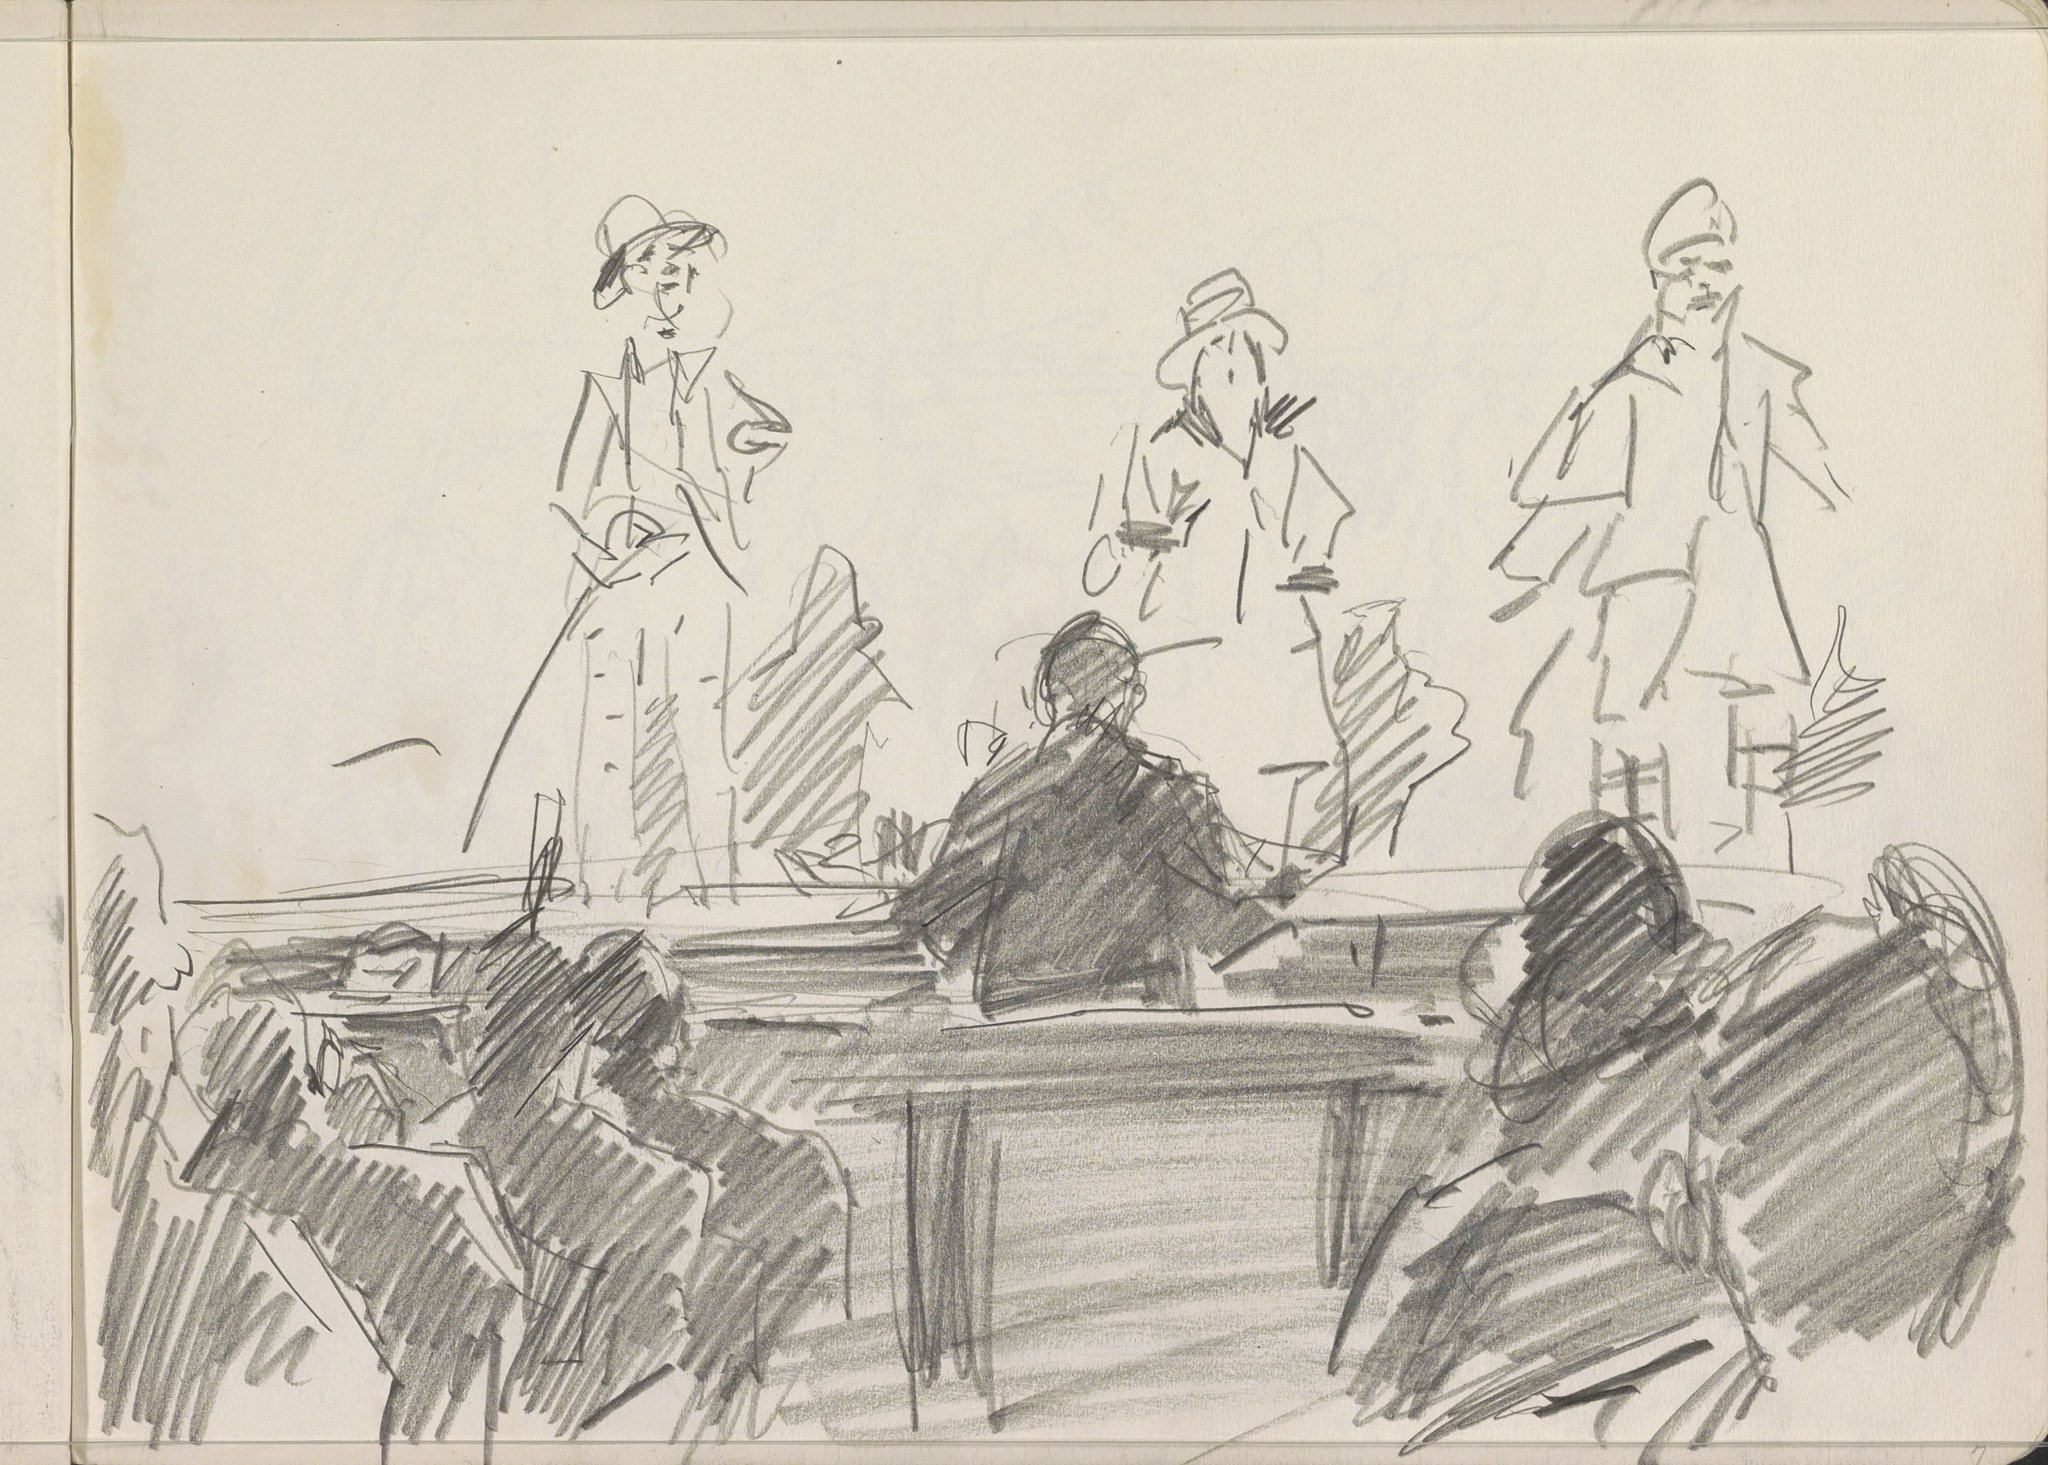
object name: sketchbook leaf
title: Theatervoorstelling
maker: isaac israels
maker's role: draughtsman, painter, print maker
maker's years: 1865-1934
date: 1875-1934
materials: paper, pencil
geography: the hague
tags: large group of musicians, orchestra, group of actors, troupe; actors on the stage, the audience ~ art performance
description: Vooraan toeschouwers, op de rug gezien. In het midden de dirigent in de orkestbak. Op het toneel drie figuren. Blad 7 recto uit schetsboek II met 23 bladen.